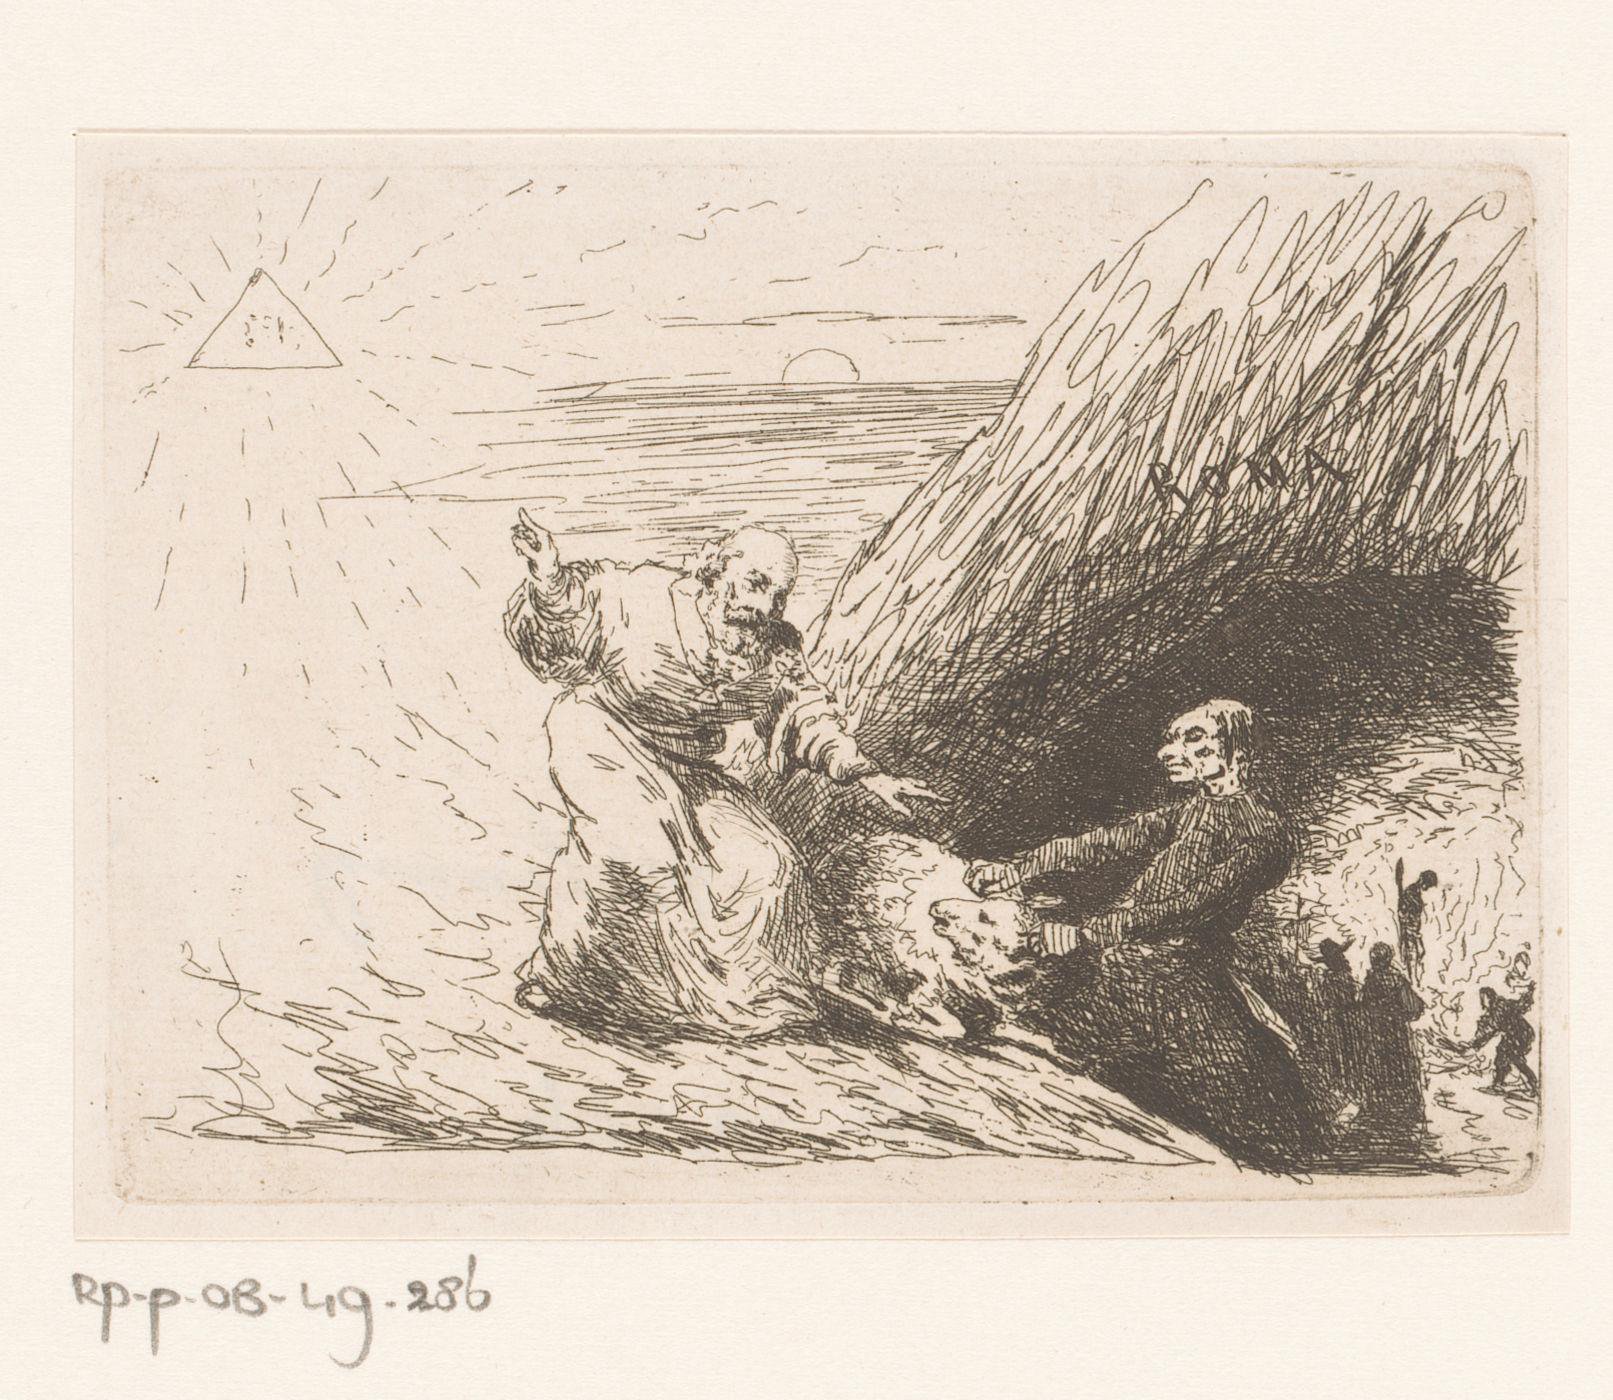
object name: print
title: Schaap wordt door twee mannen een grot in gesleurd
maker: willem linnig (i)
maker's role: print maker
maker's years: 1819-1885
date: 1829-1885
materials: paper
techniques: etching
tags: violent death by burning at the stake; pyre, sheep, cave, grotto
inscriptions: collector's mark: Lugt 2228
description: Boven de ingang van de grot het woord "Roma". Binnenin de grot staat een persoon op een brandstapel omringd door toeschouwers.